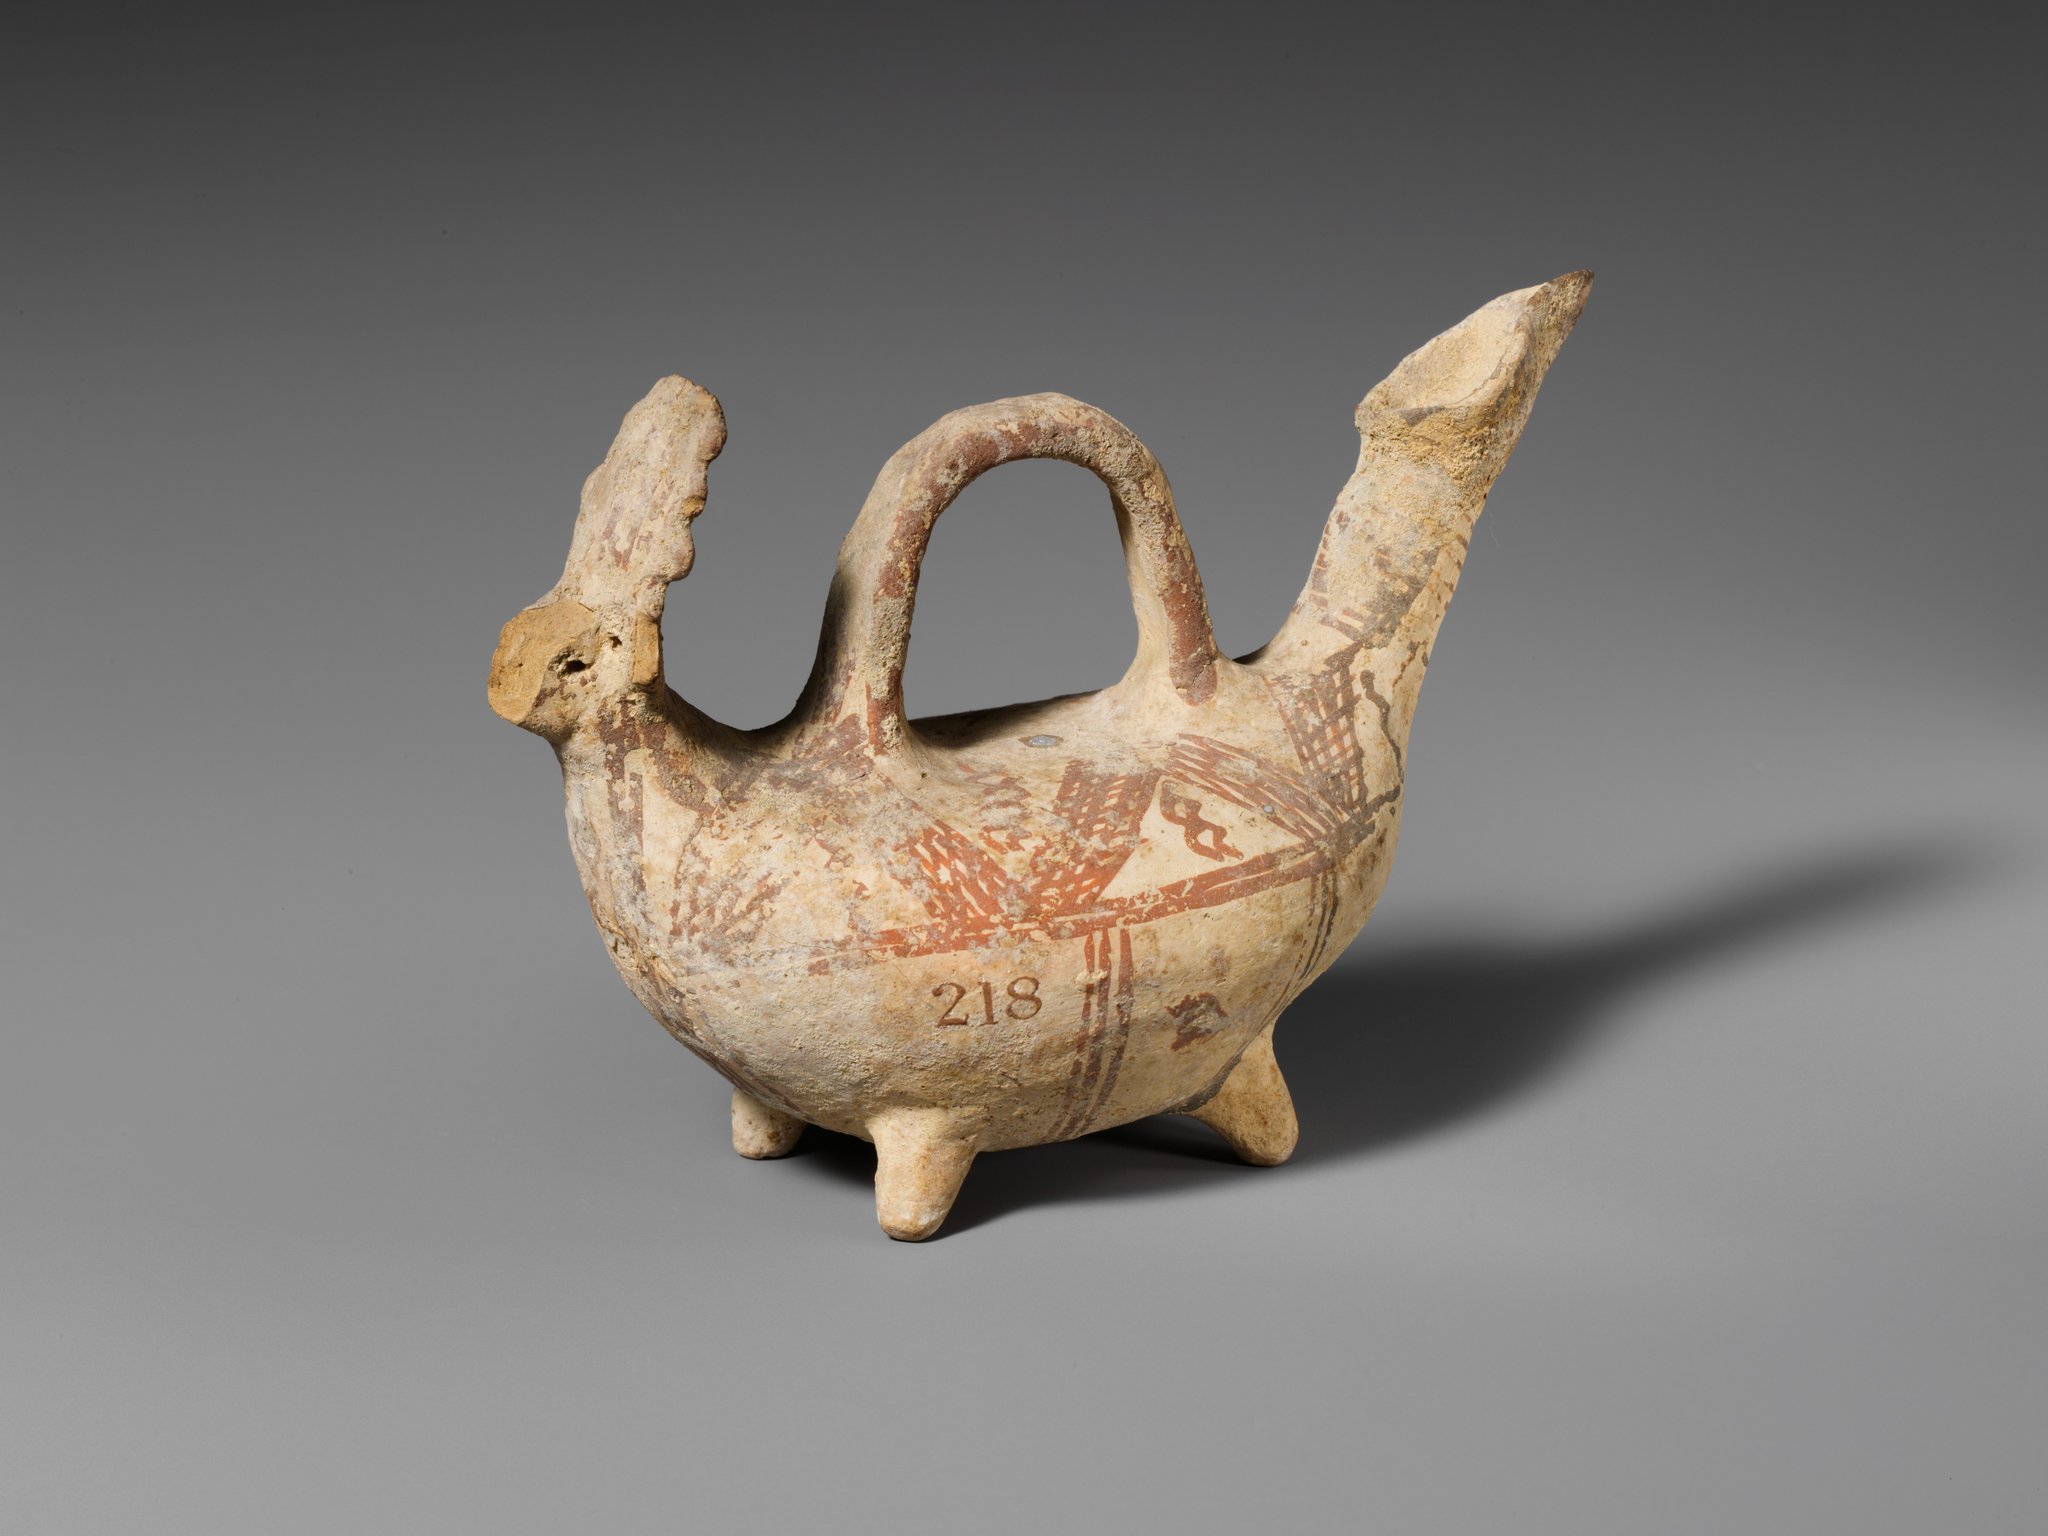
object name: vase in the form of an animal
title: Terracotta zoomorphic askos (vessel)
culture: cypriot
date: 1900-1600 BCE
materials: terracotta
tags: animals